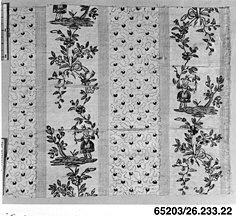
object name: fragment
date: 1801-1900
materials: cotton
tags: human figures,leaves